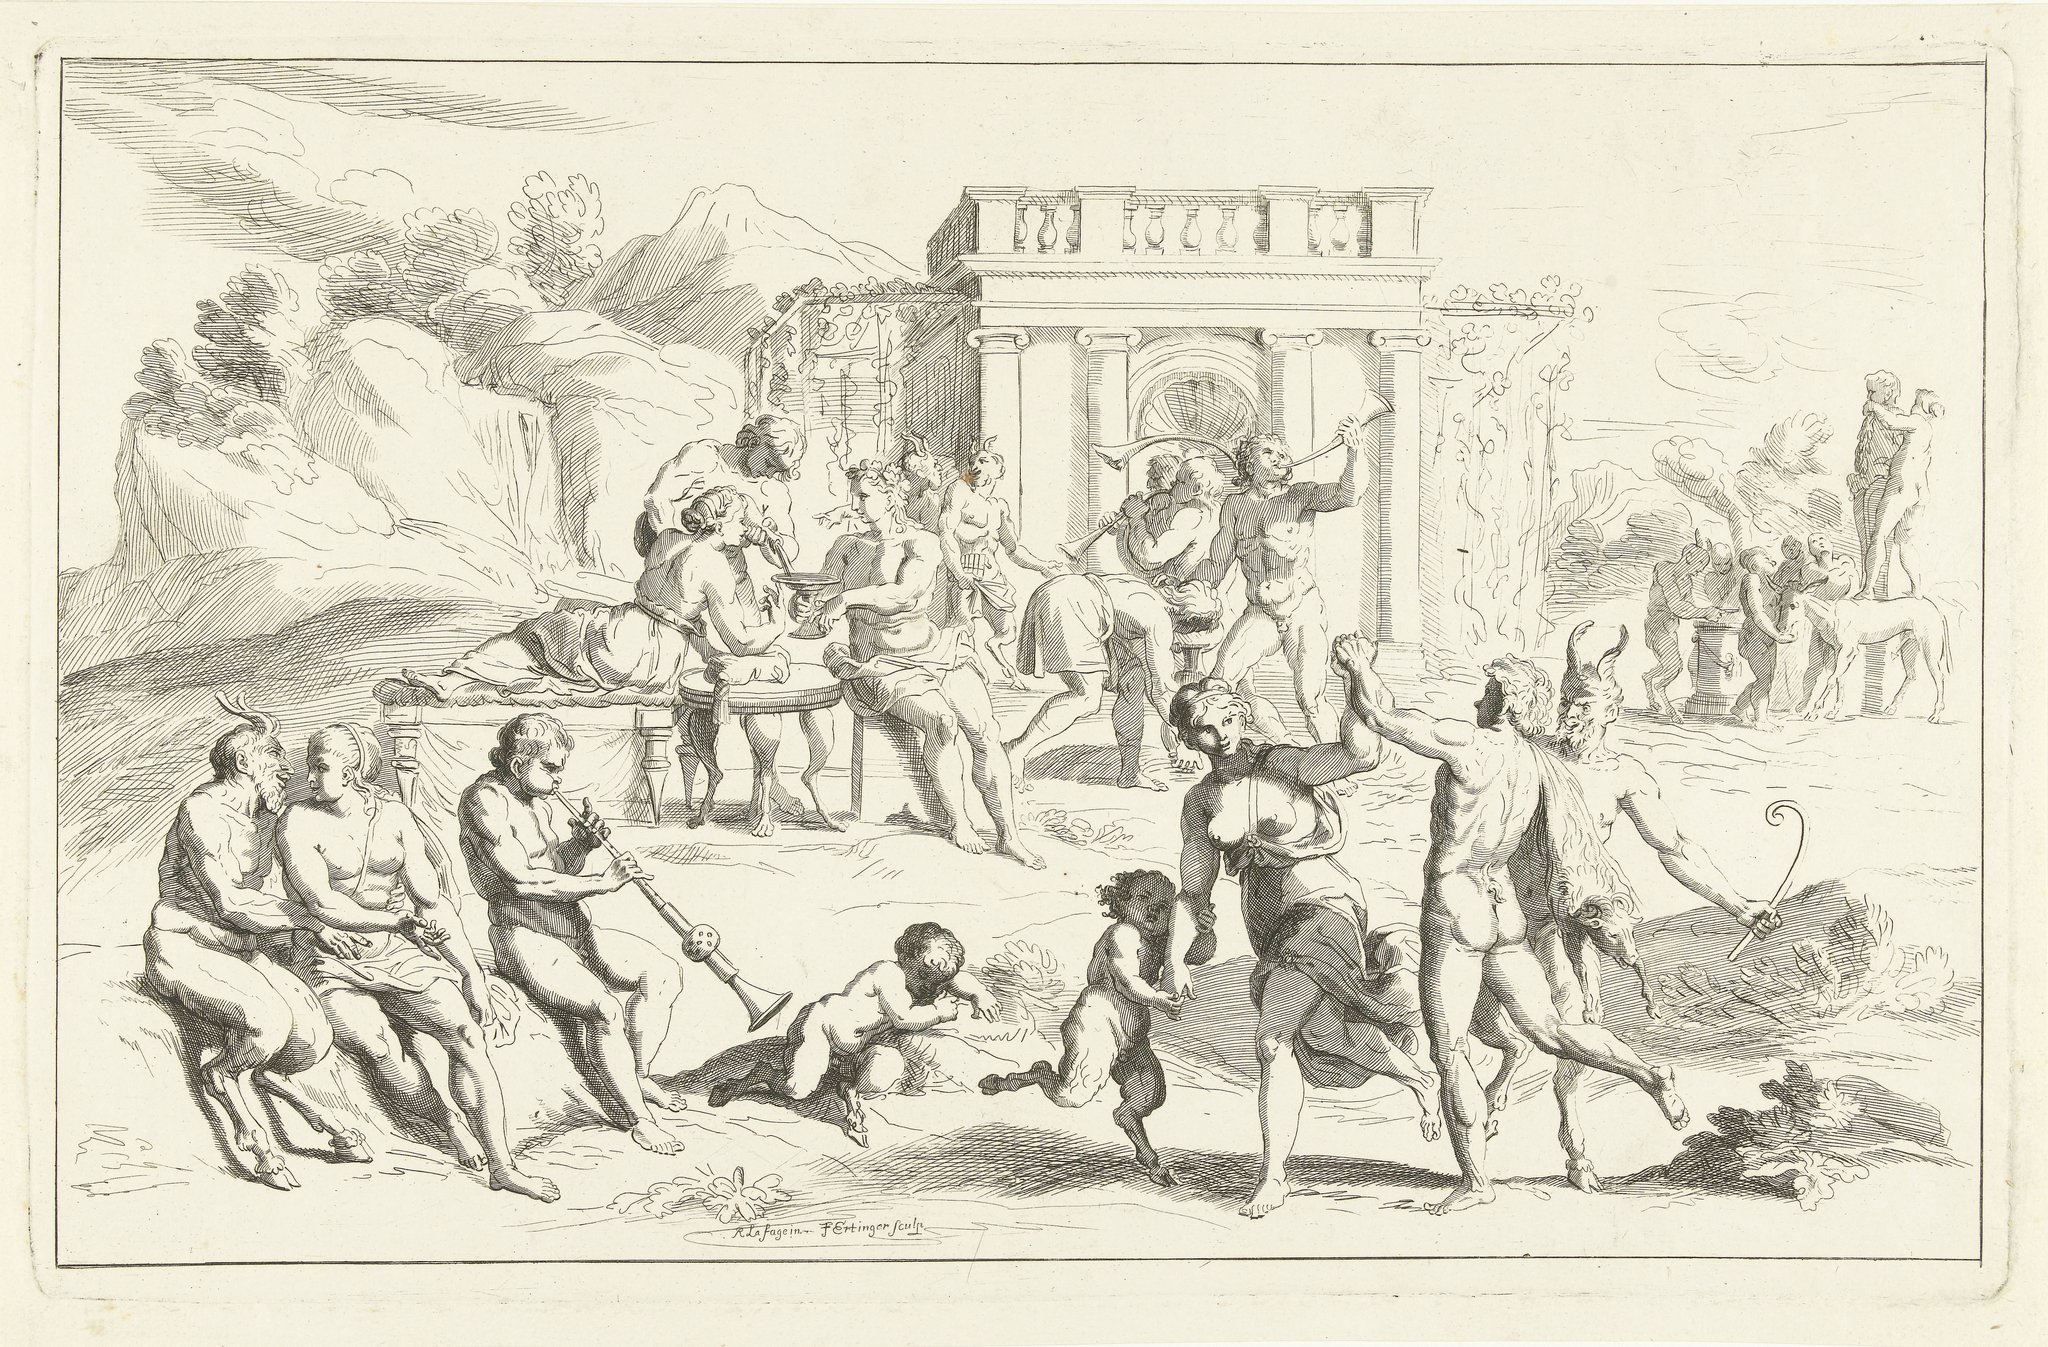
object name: print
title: Feestende satyrs en bacchanten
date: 1652-1707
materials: paper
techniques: engraving, etching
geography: paris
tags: veneration of bacchus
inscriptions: collector's mark: Lugt 2165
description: Bacchanaal met hoornblazers in de tuin van een villa. Op de voorgrond dansen een naakte man met geitenvel over zijn schouder en een halfnaakte vrouw in het bijzijn van een satyr en kind.